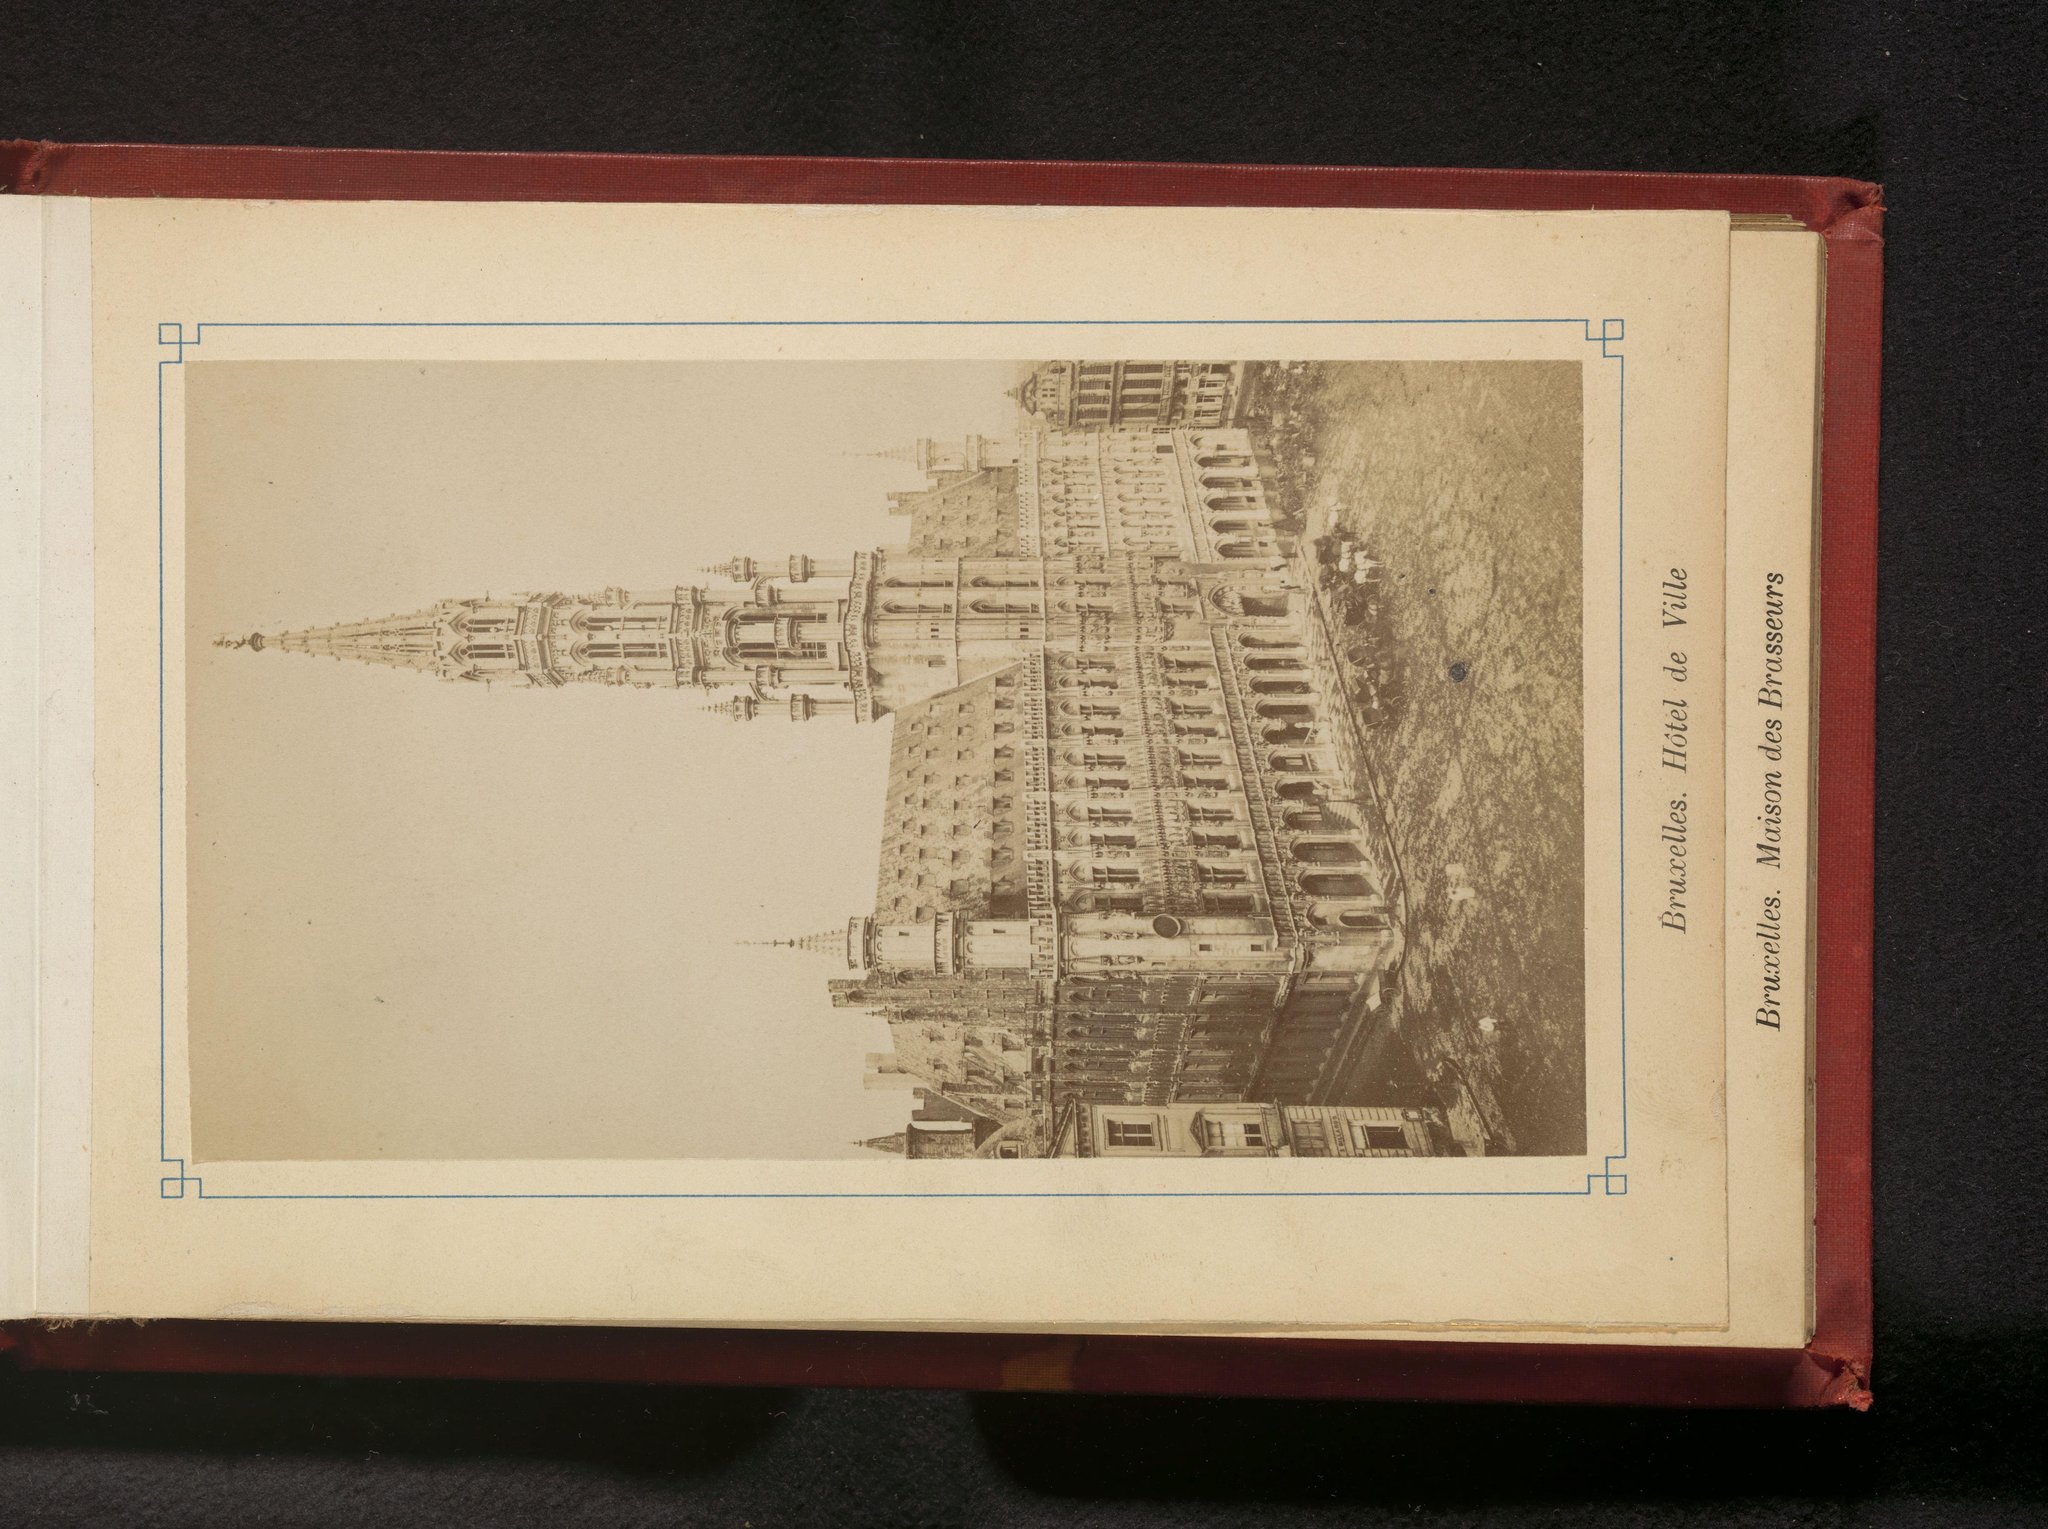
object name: page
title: Stadhuis van Brussel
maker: Anonymous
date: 1875-1880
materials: photographic support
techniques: albumen print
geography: brussels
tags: townhall, brussels